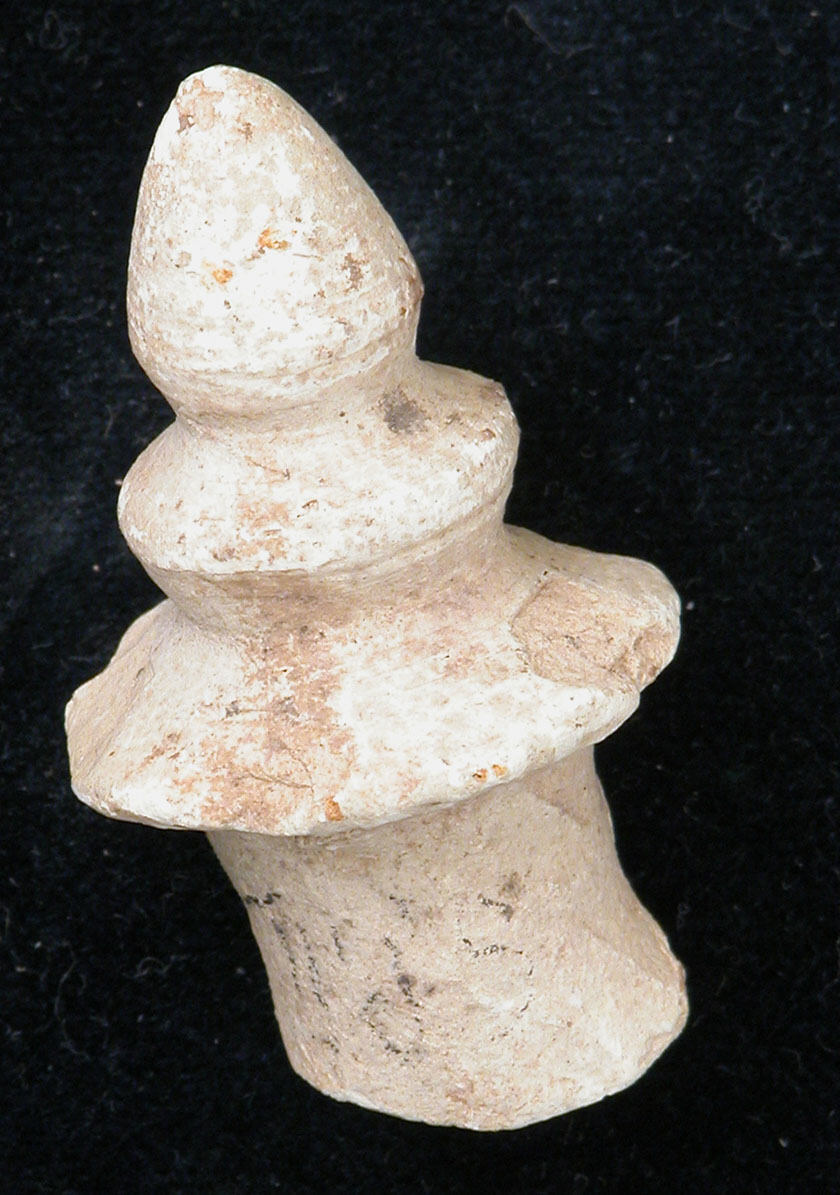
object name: fragment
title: Fragment of a Turban-Shaped Thumb Rest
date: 801-1100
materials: earthenware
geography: iraq